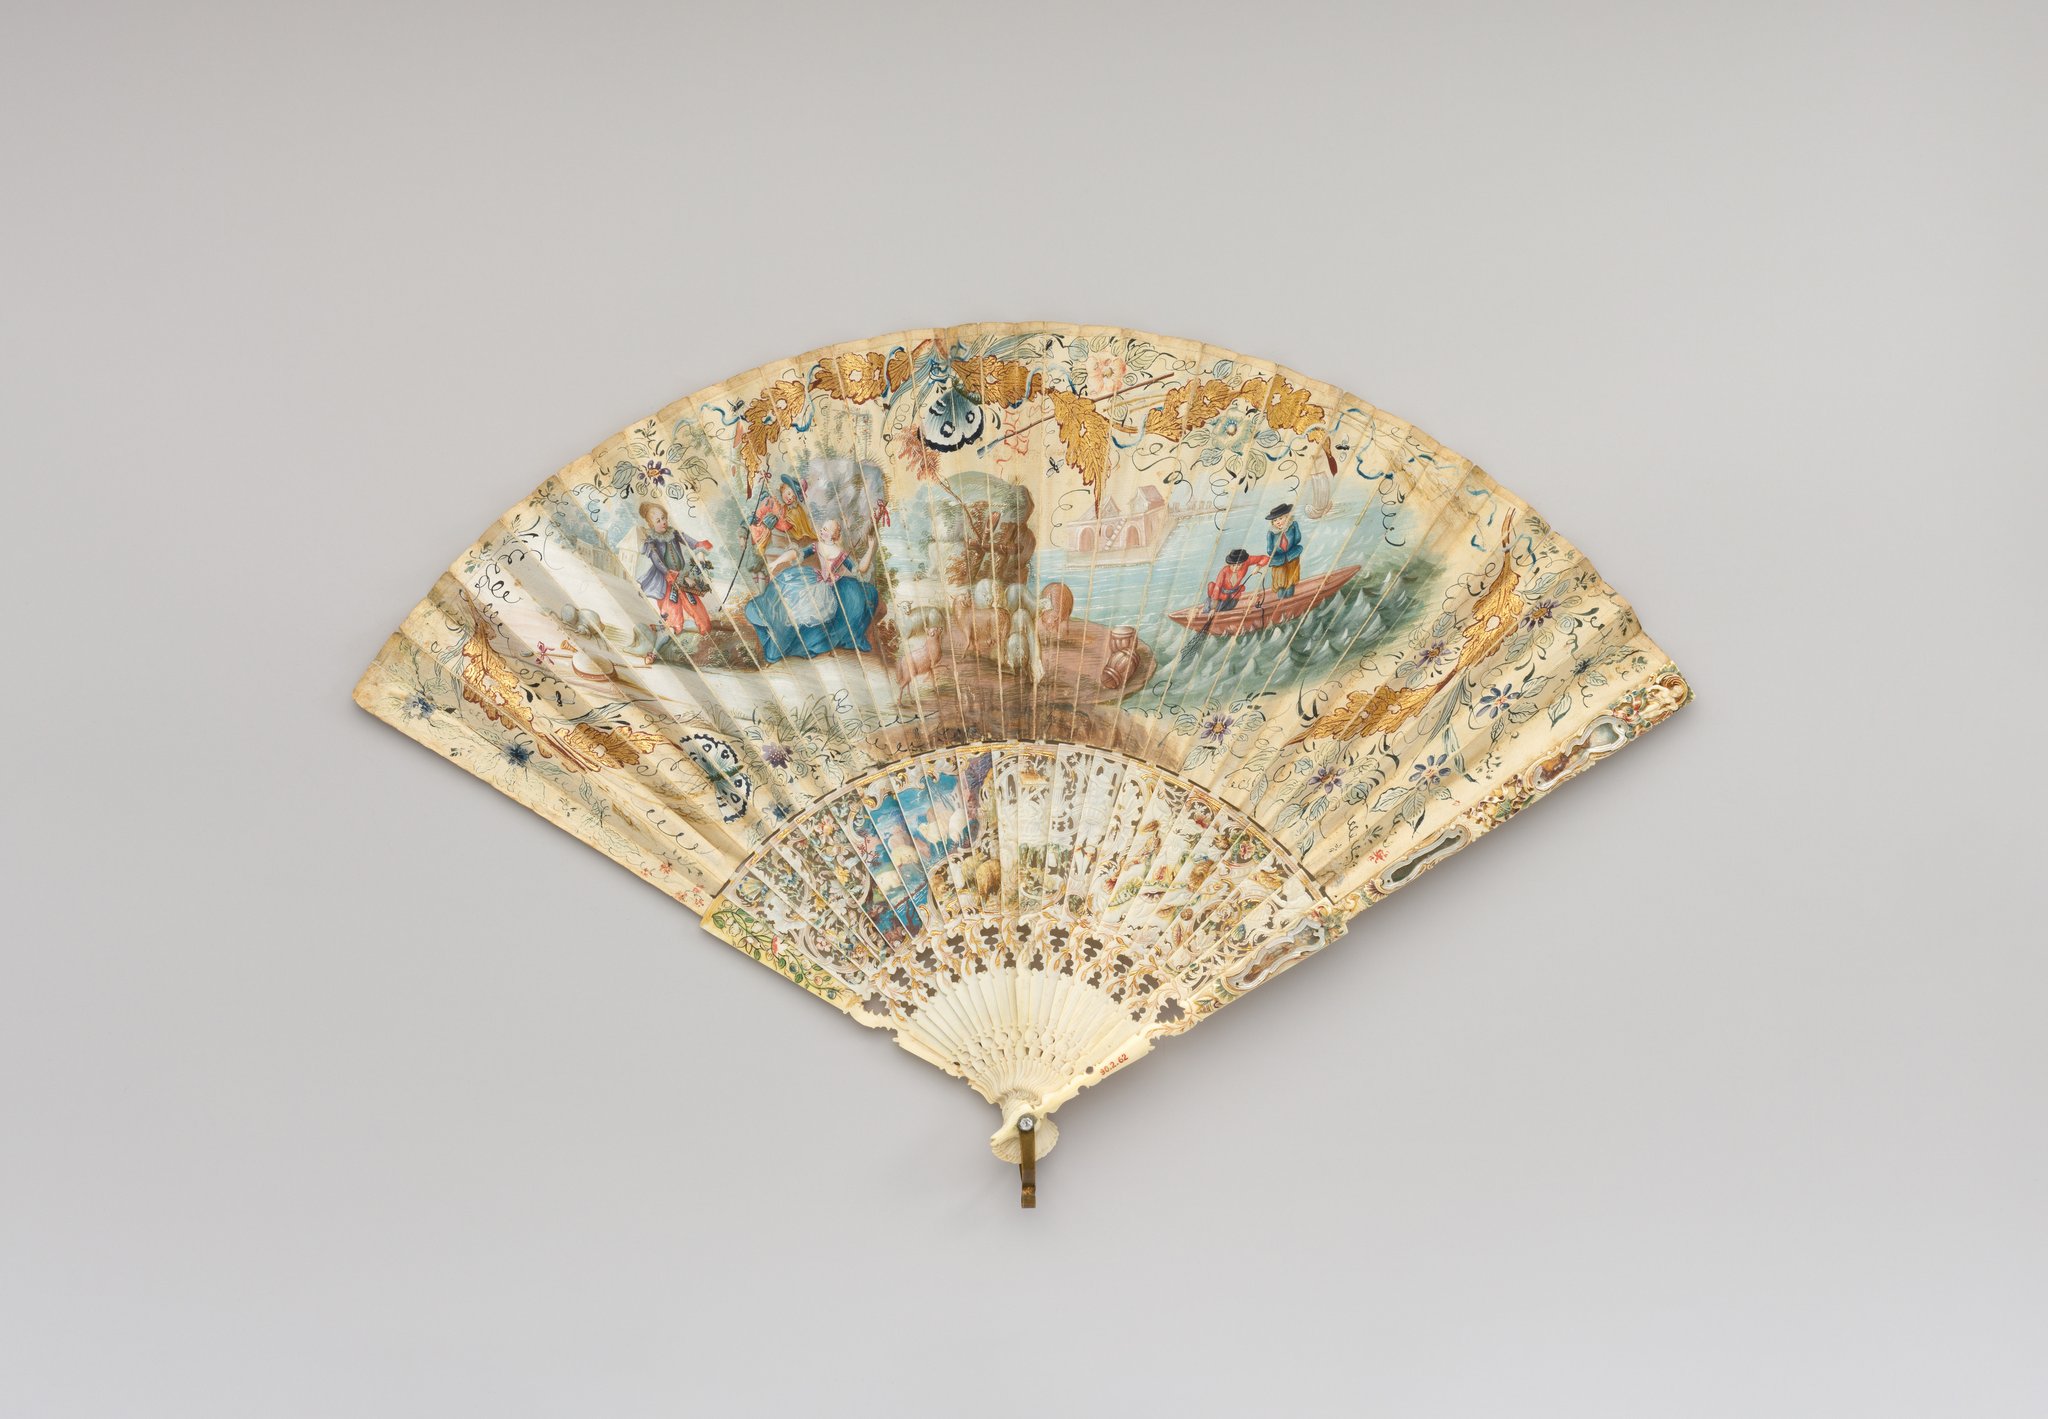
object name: fan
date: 1750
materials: gilt, ivory, paint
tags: animals,men,women,boats